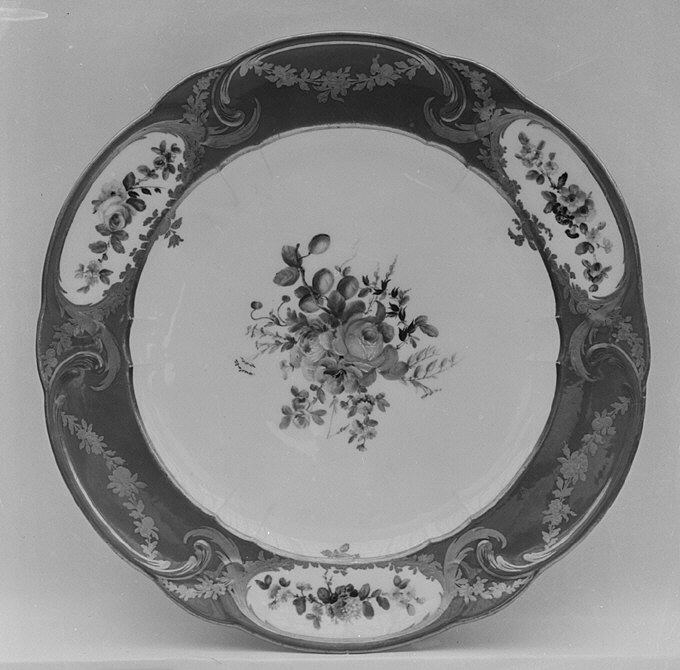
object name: plate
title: Plate (assiette à palmes) (1 of 102) (part of a service)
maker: sèvres manufactory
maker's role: manufactory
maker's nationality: french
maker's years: 1740-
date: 1772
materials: soft paste porcelain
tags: flowers